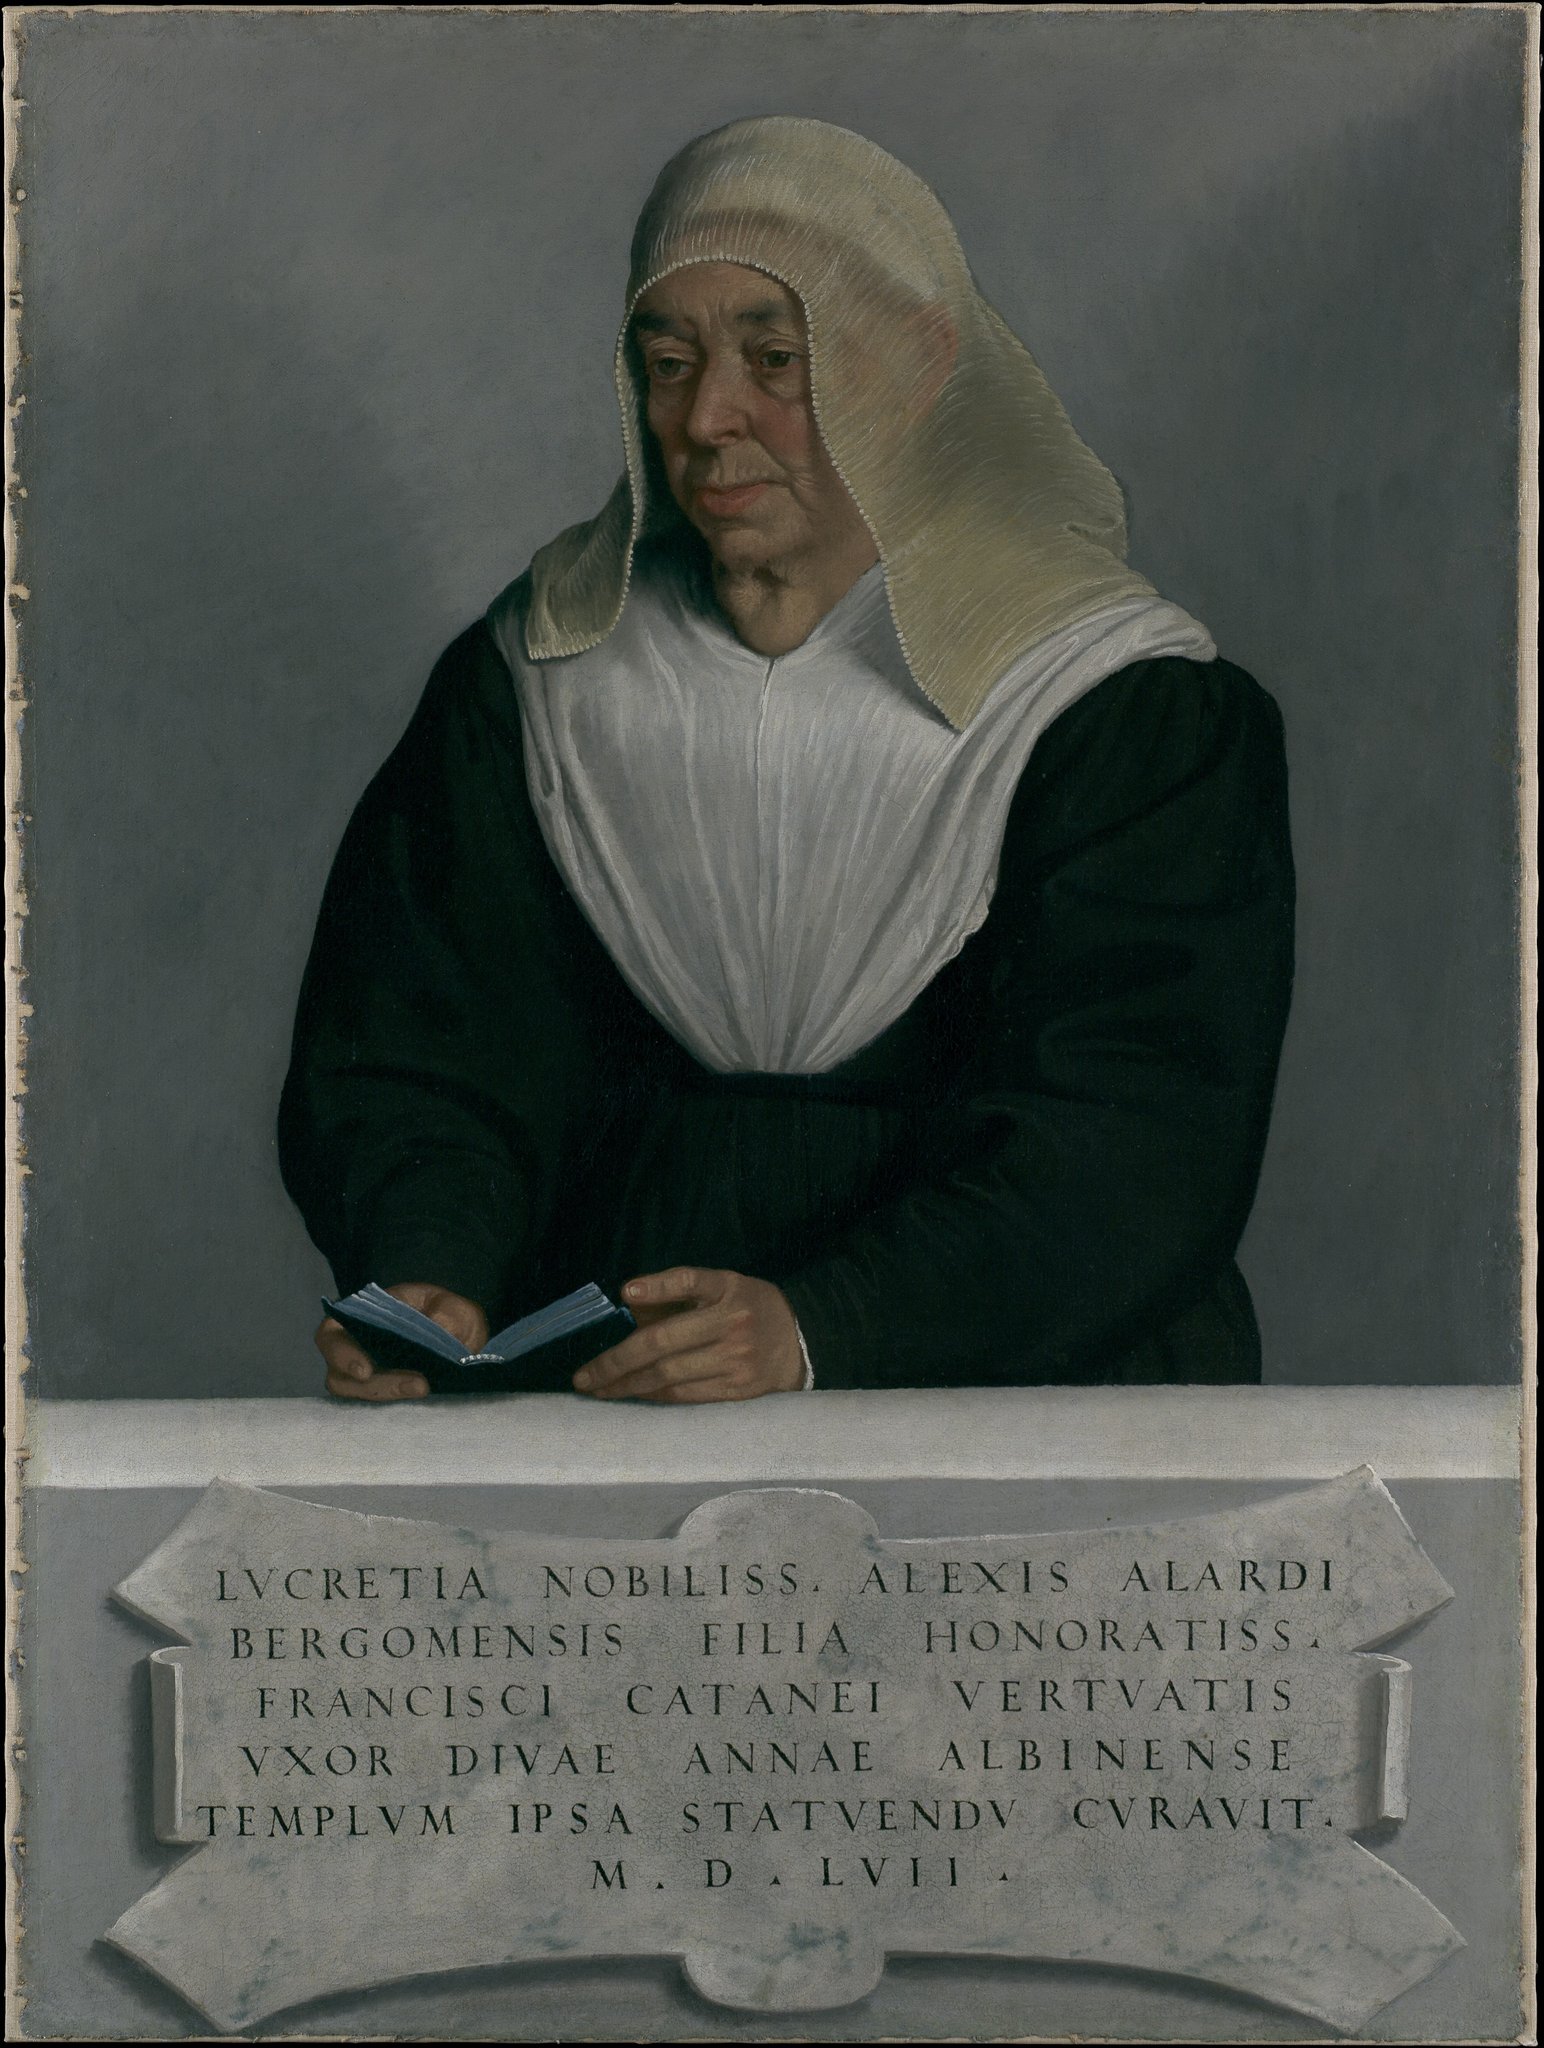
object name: painting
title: Lucrezia Agliardi Vertova (1490?–1558)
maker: giovanni battista moroni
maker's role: artist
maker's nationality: italian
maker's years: 1524-1578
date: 1557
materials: canvas, oil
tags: portraits,women